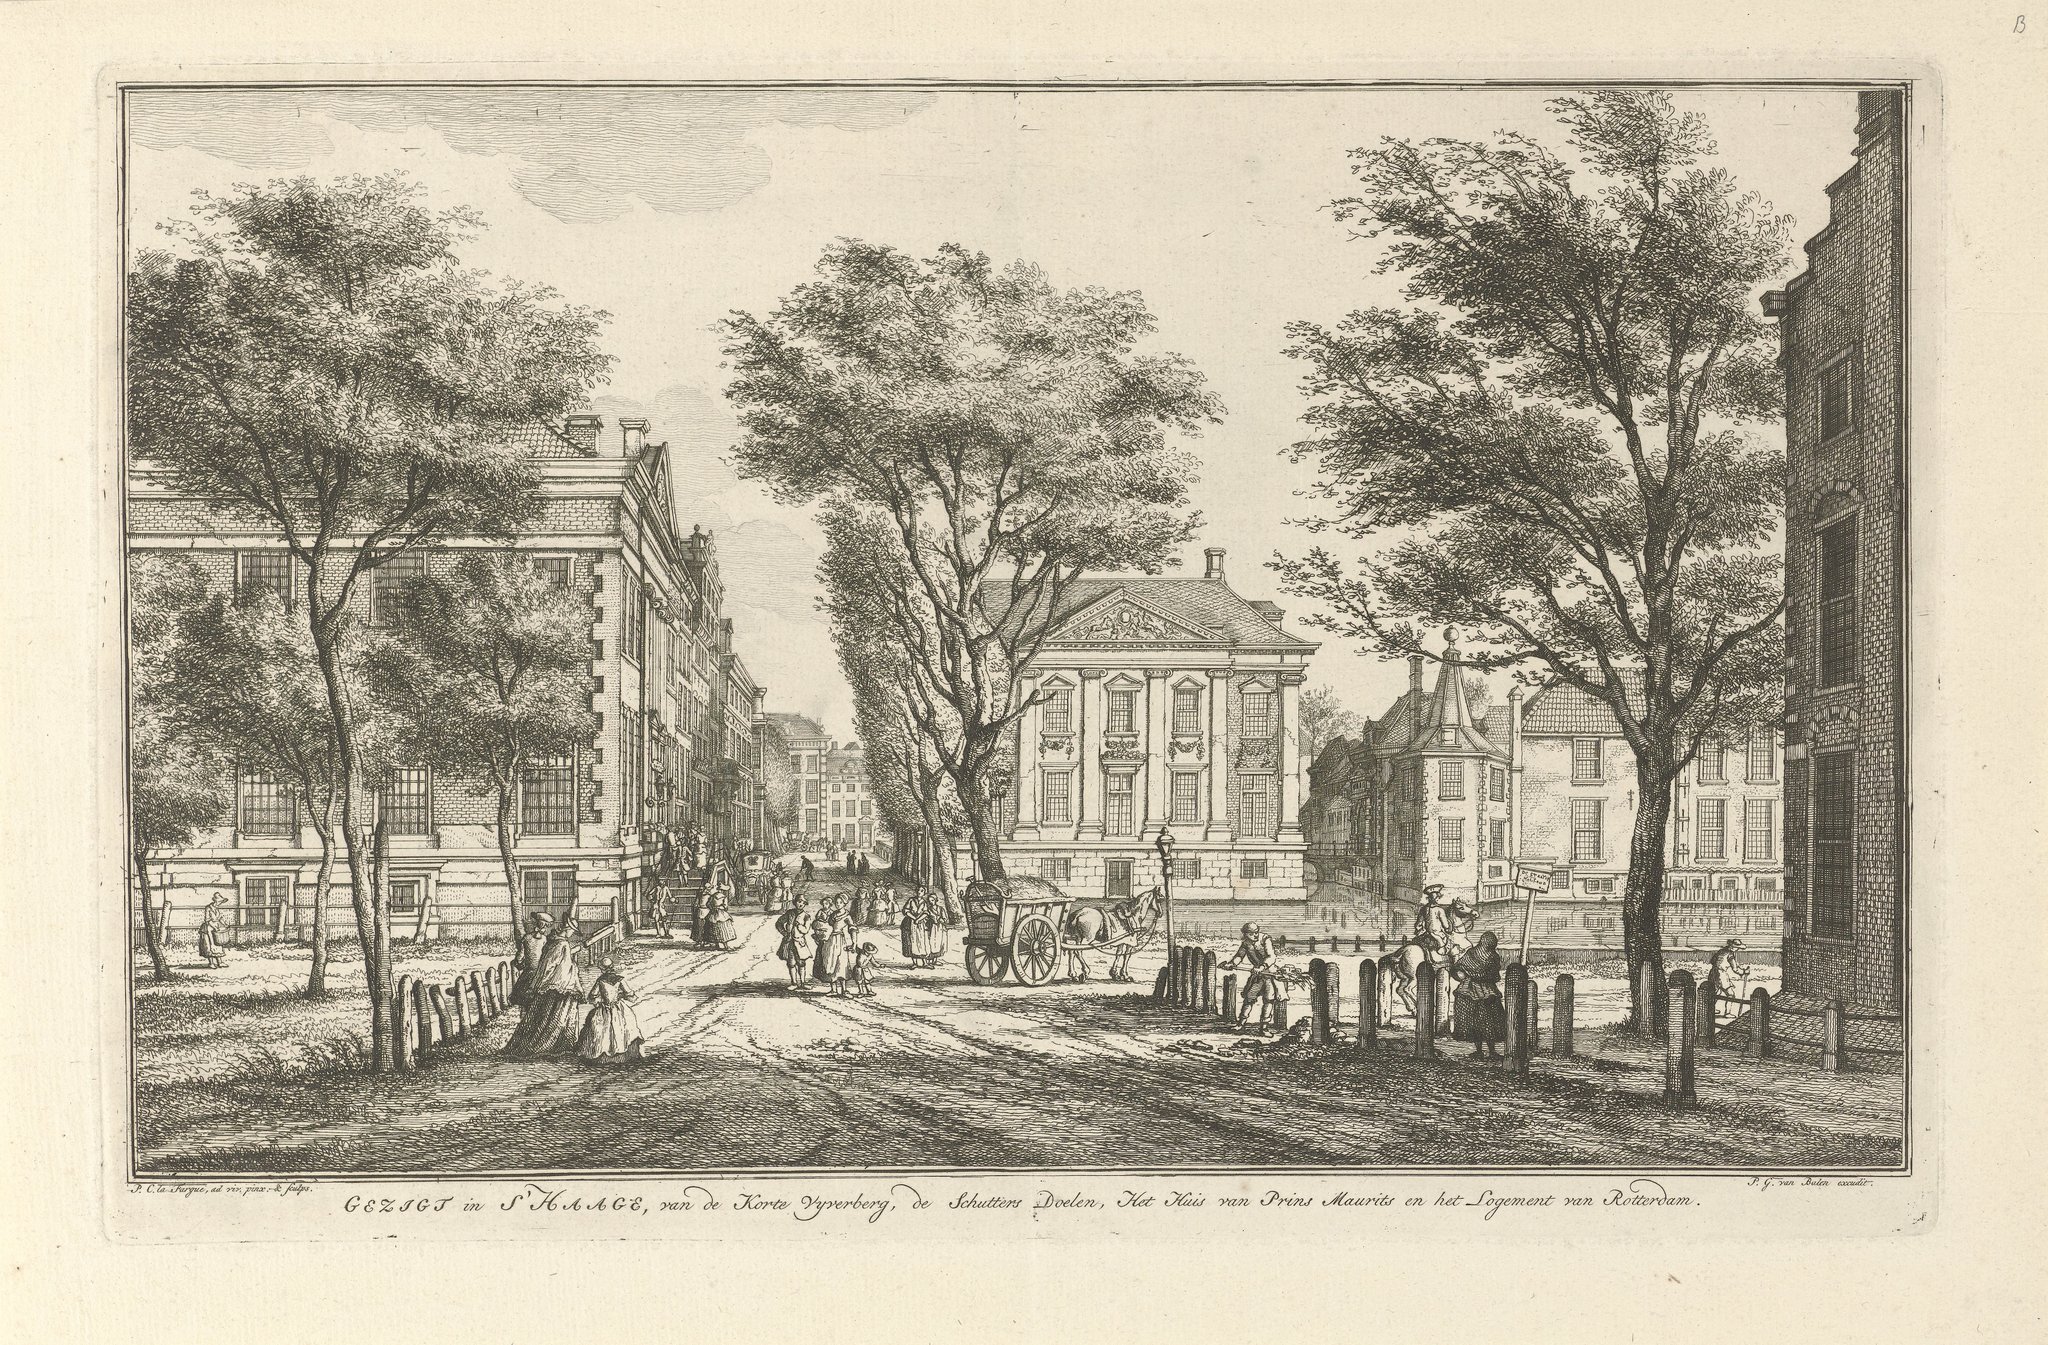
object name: print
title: Gezicht vanaf de Korte Vijverberg te Den Haag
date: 1747-1765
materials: paper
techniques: etching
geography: the hague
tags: city-view, and landscape with man-made constructions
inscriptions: collector's mark: Lugt 2228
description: De Korte Vijverberg, op de hoek van het Toernooiveld, gezien naar het Plein. Rechts het Mauritshuis en de vijverzijde van het Binnenhofcomplex. Op straat wandelen figuren.